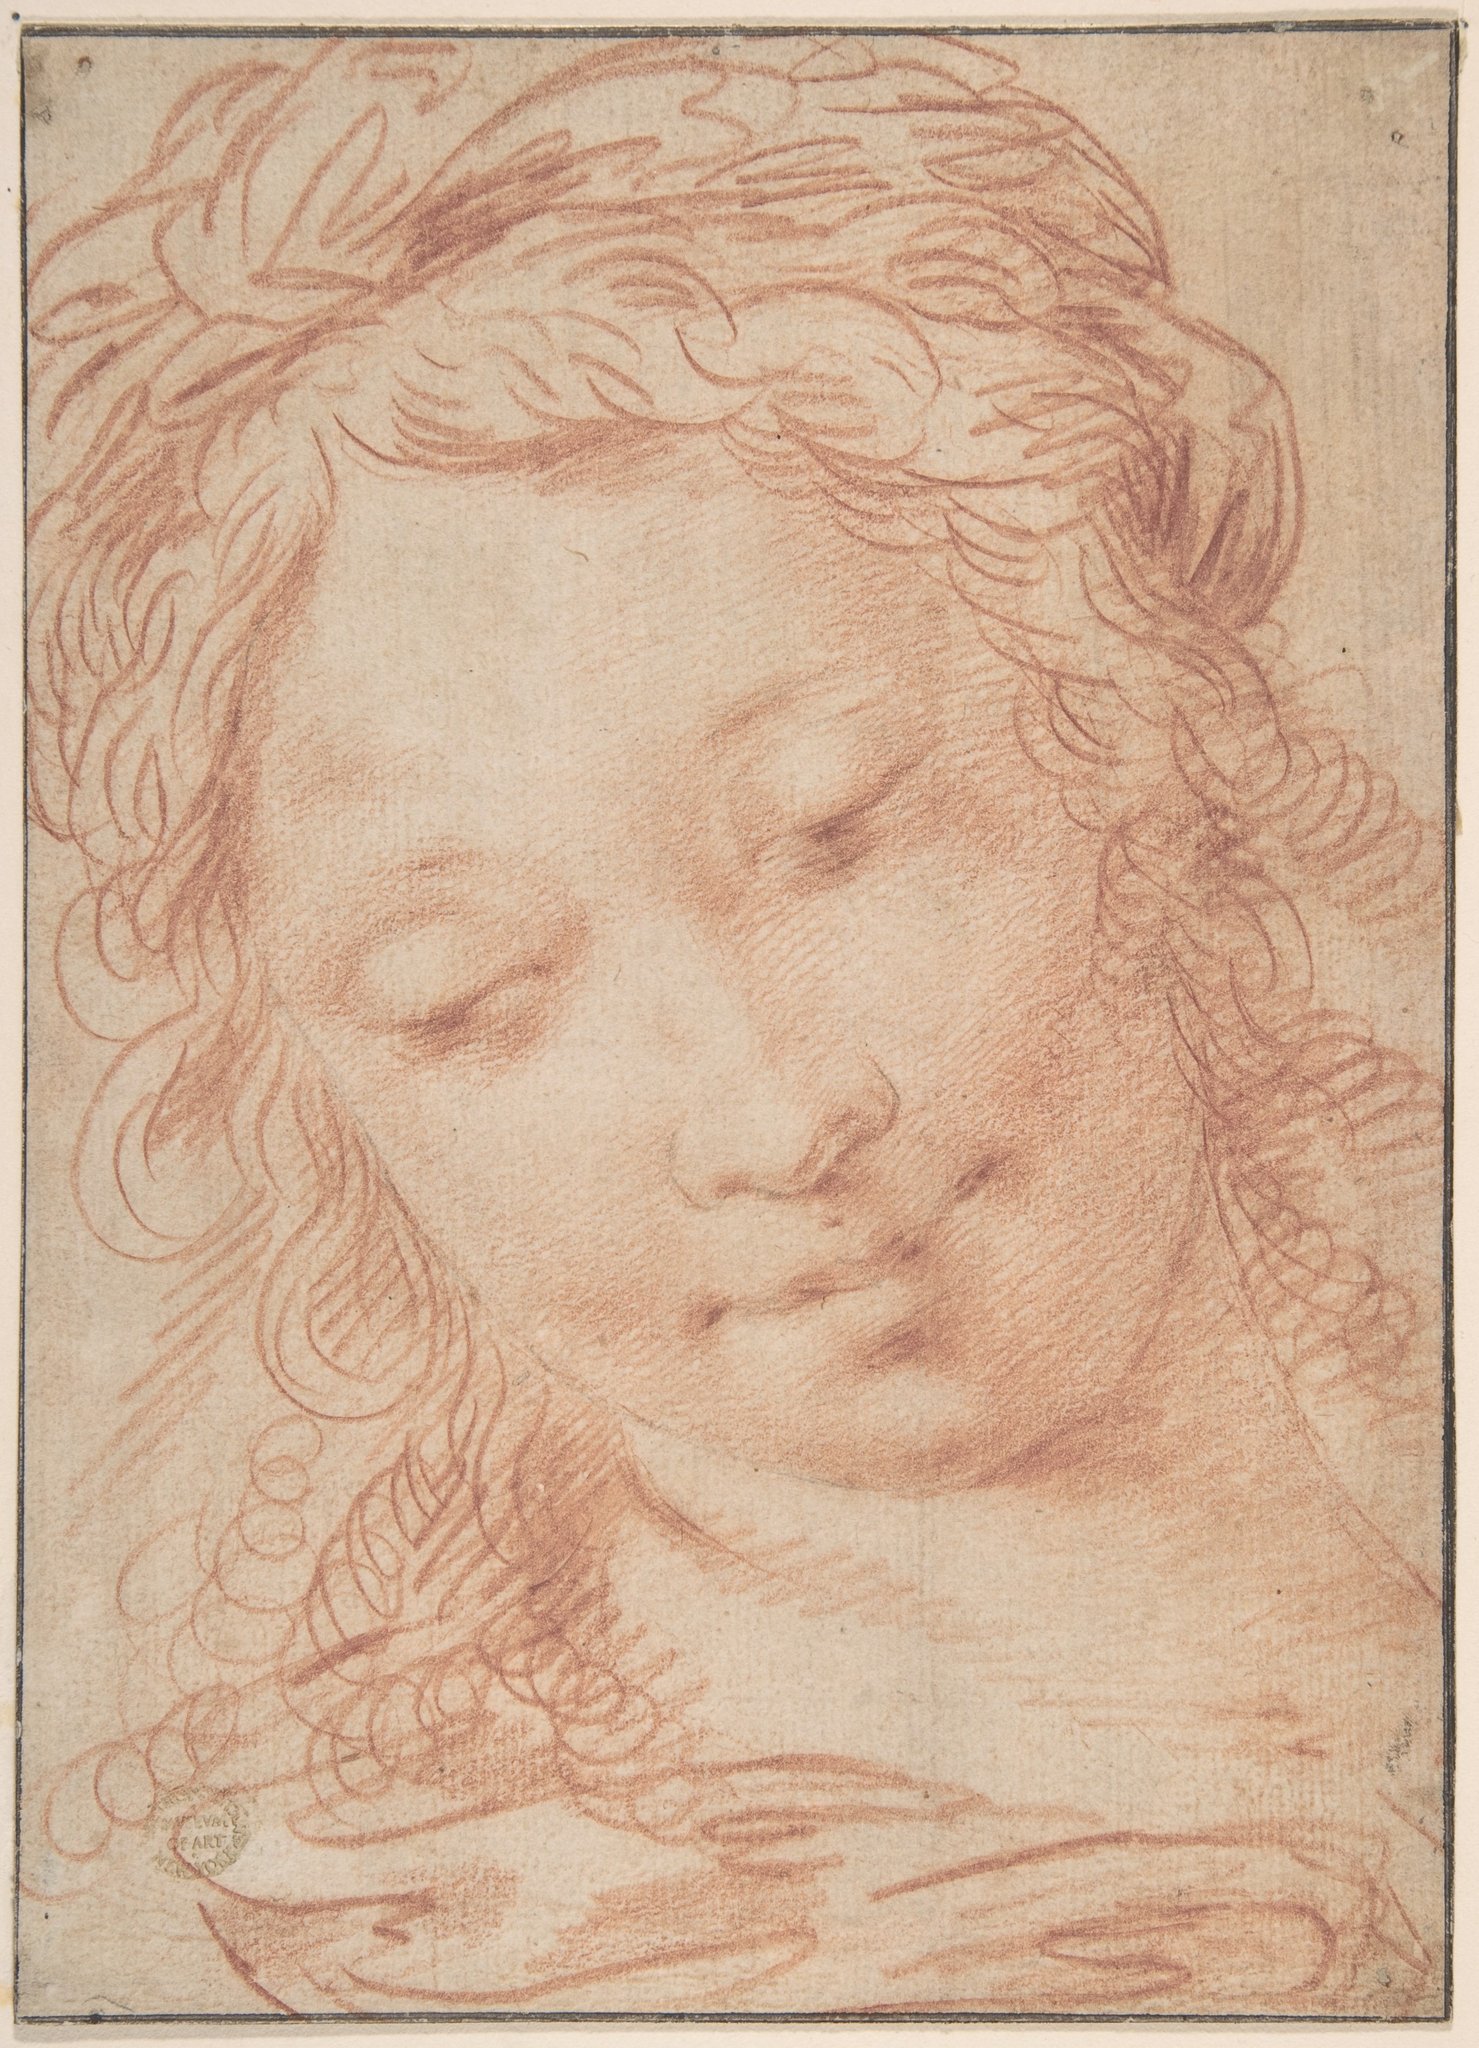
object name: drawing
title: Female Head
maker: anonymous, italian, roman-bolognese, 17th century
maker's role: artist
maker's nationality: italian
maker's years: 1600-1700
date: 1601-1700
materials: chalk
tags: heads,portraits,women